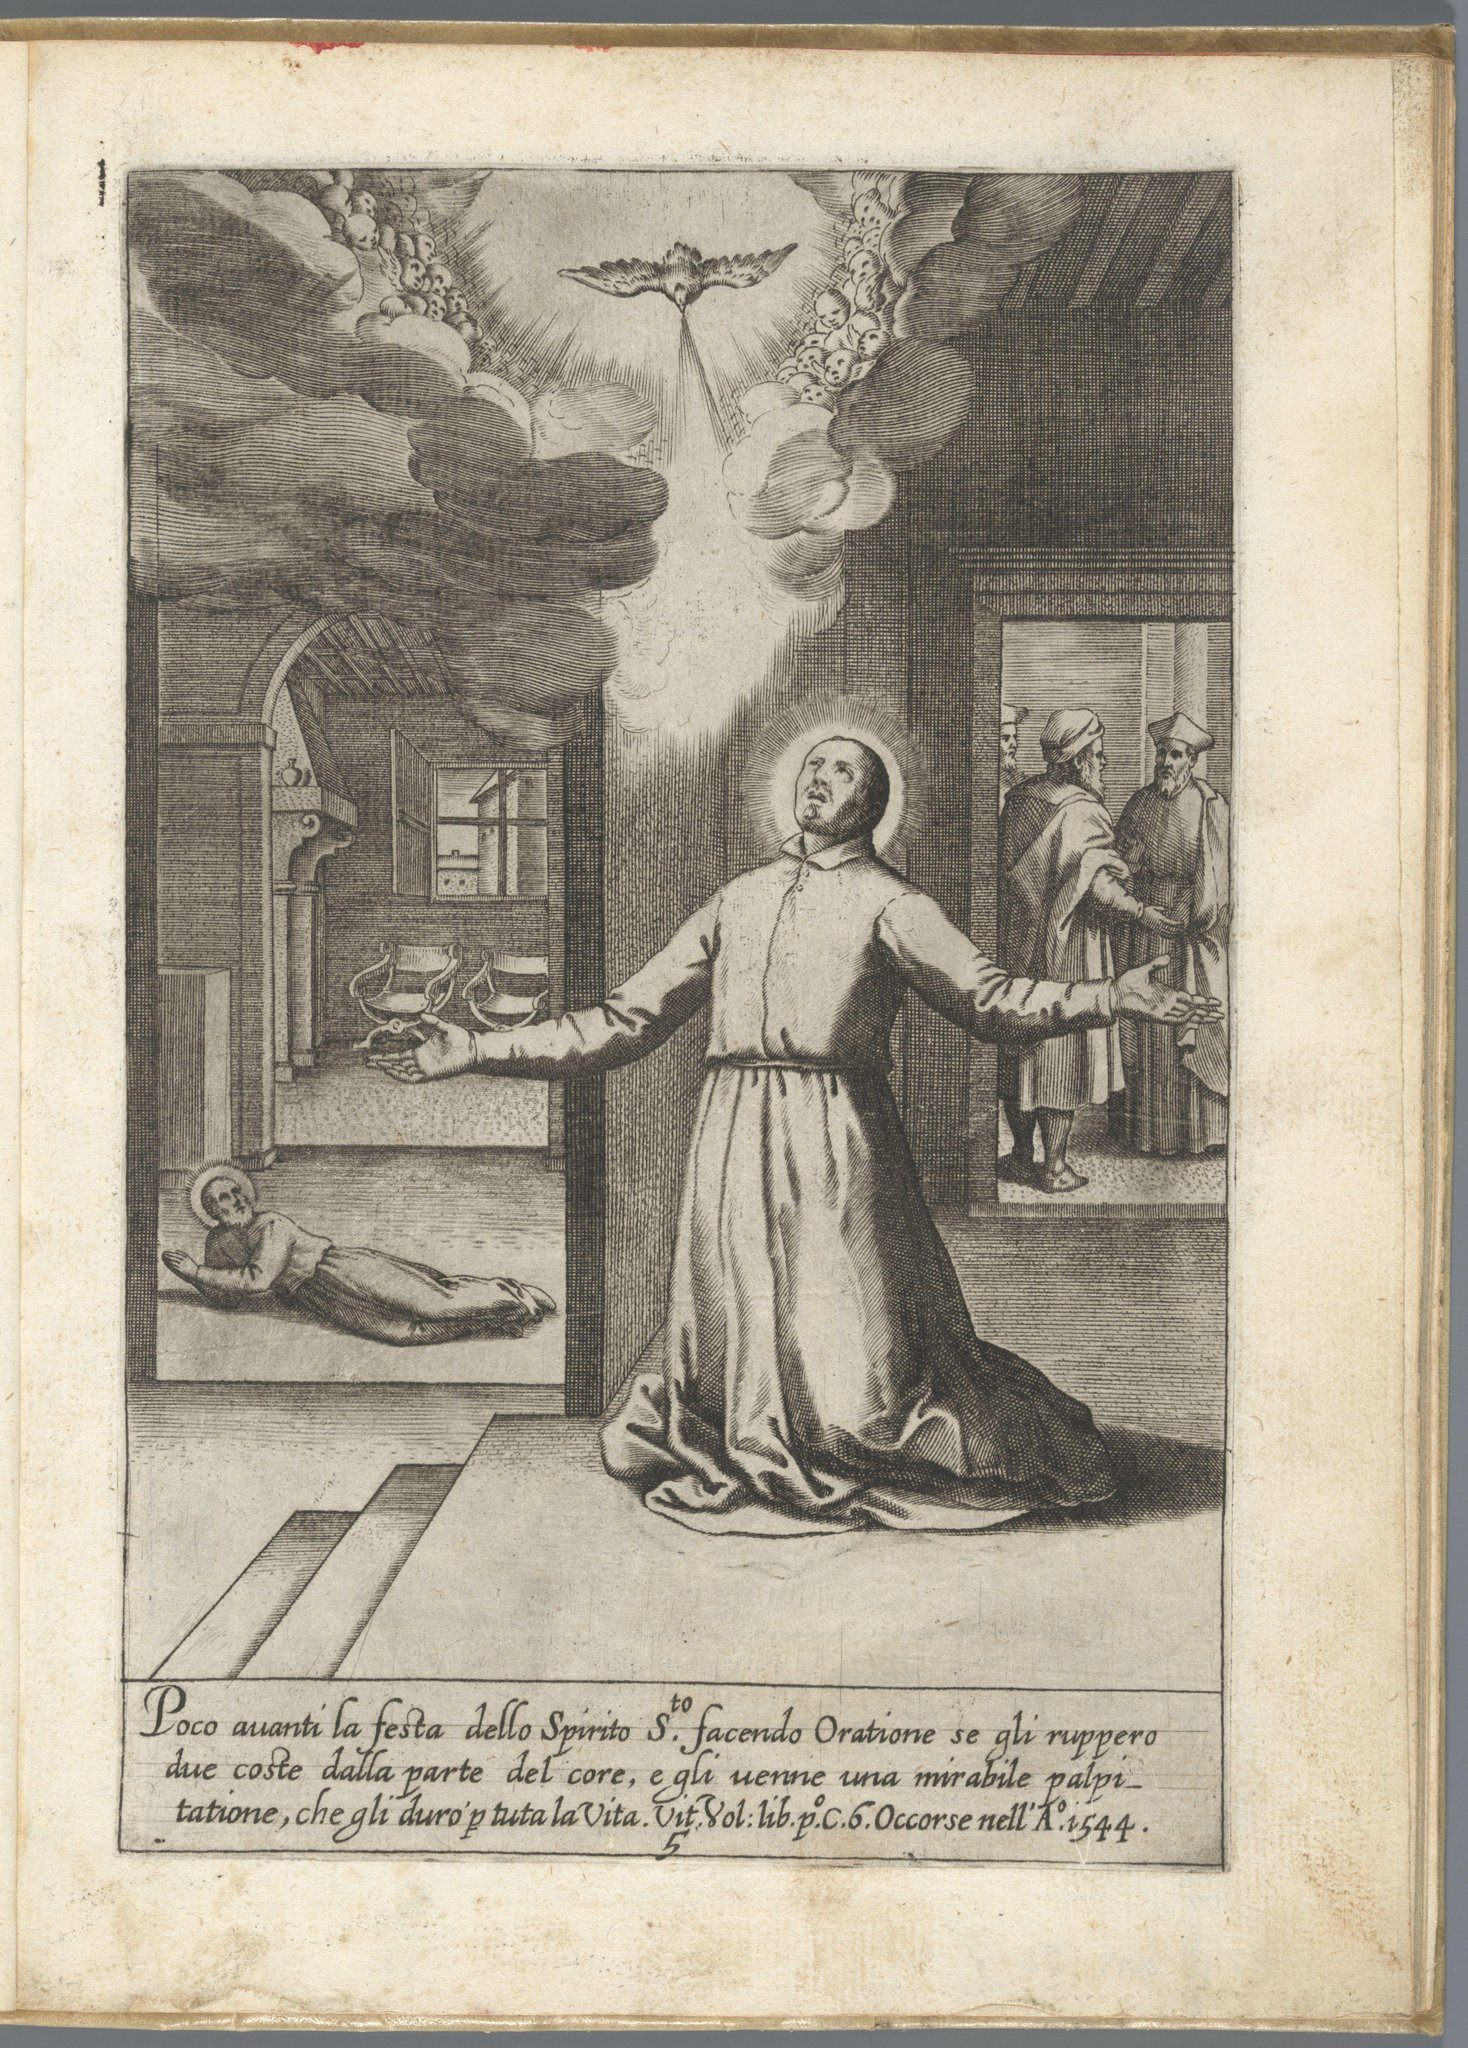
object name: print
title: Filippo Neri breekt twee ribben tijdens het bidden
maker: luca ciamberlano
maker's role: painter, print maker, publisher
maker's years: 1570-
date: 1630-1641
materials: paper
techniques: engraving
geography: rome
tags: rome, clergyman, the founder of the congregation of the oratory (oratorians) philip neri; possible attributes: lily, rosary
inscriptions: collector's mark: Lugt 2760, collector's mark: Lugt 2228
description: Filippo Neri breekt twee ribben tijdens het bidden, hij voelt Filippo Neri voor de rest van zijn leven een klopping (1544). Filippo Neri knielt op de vloer voor de Heilige Geest in de vorm van een duif. Prent nr. 5 in een serie van 44 prenten met scènes uit het leven van de heilige Filippo Neri.